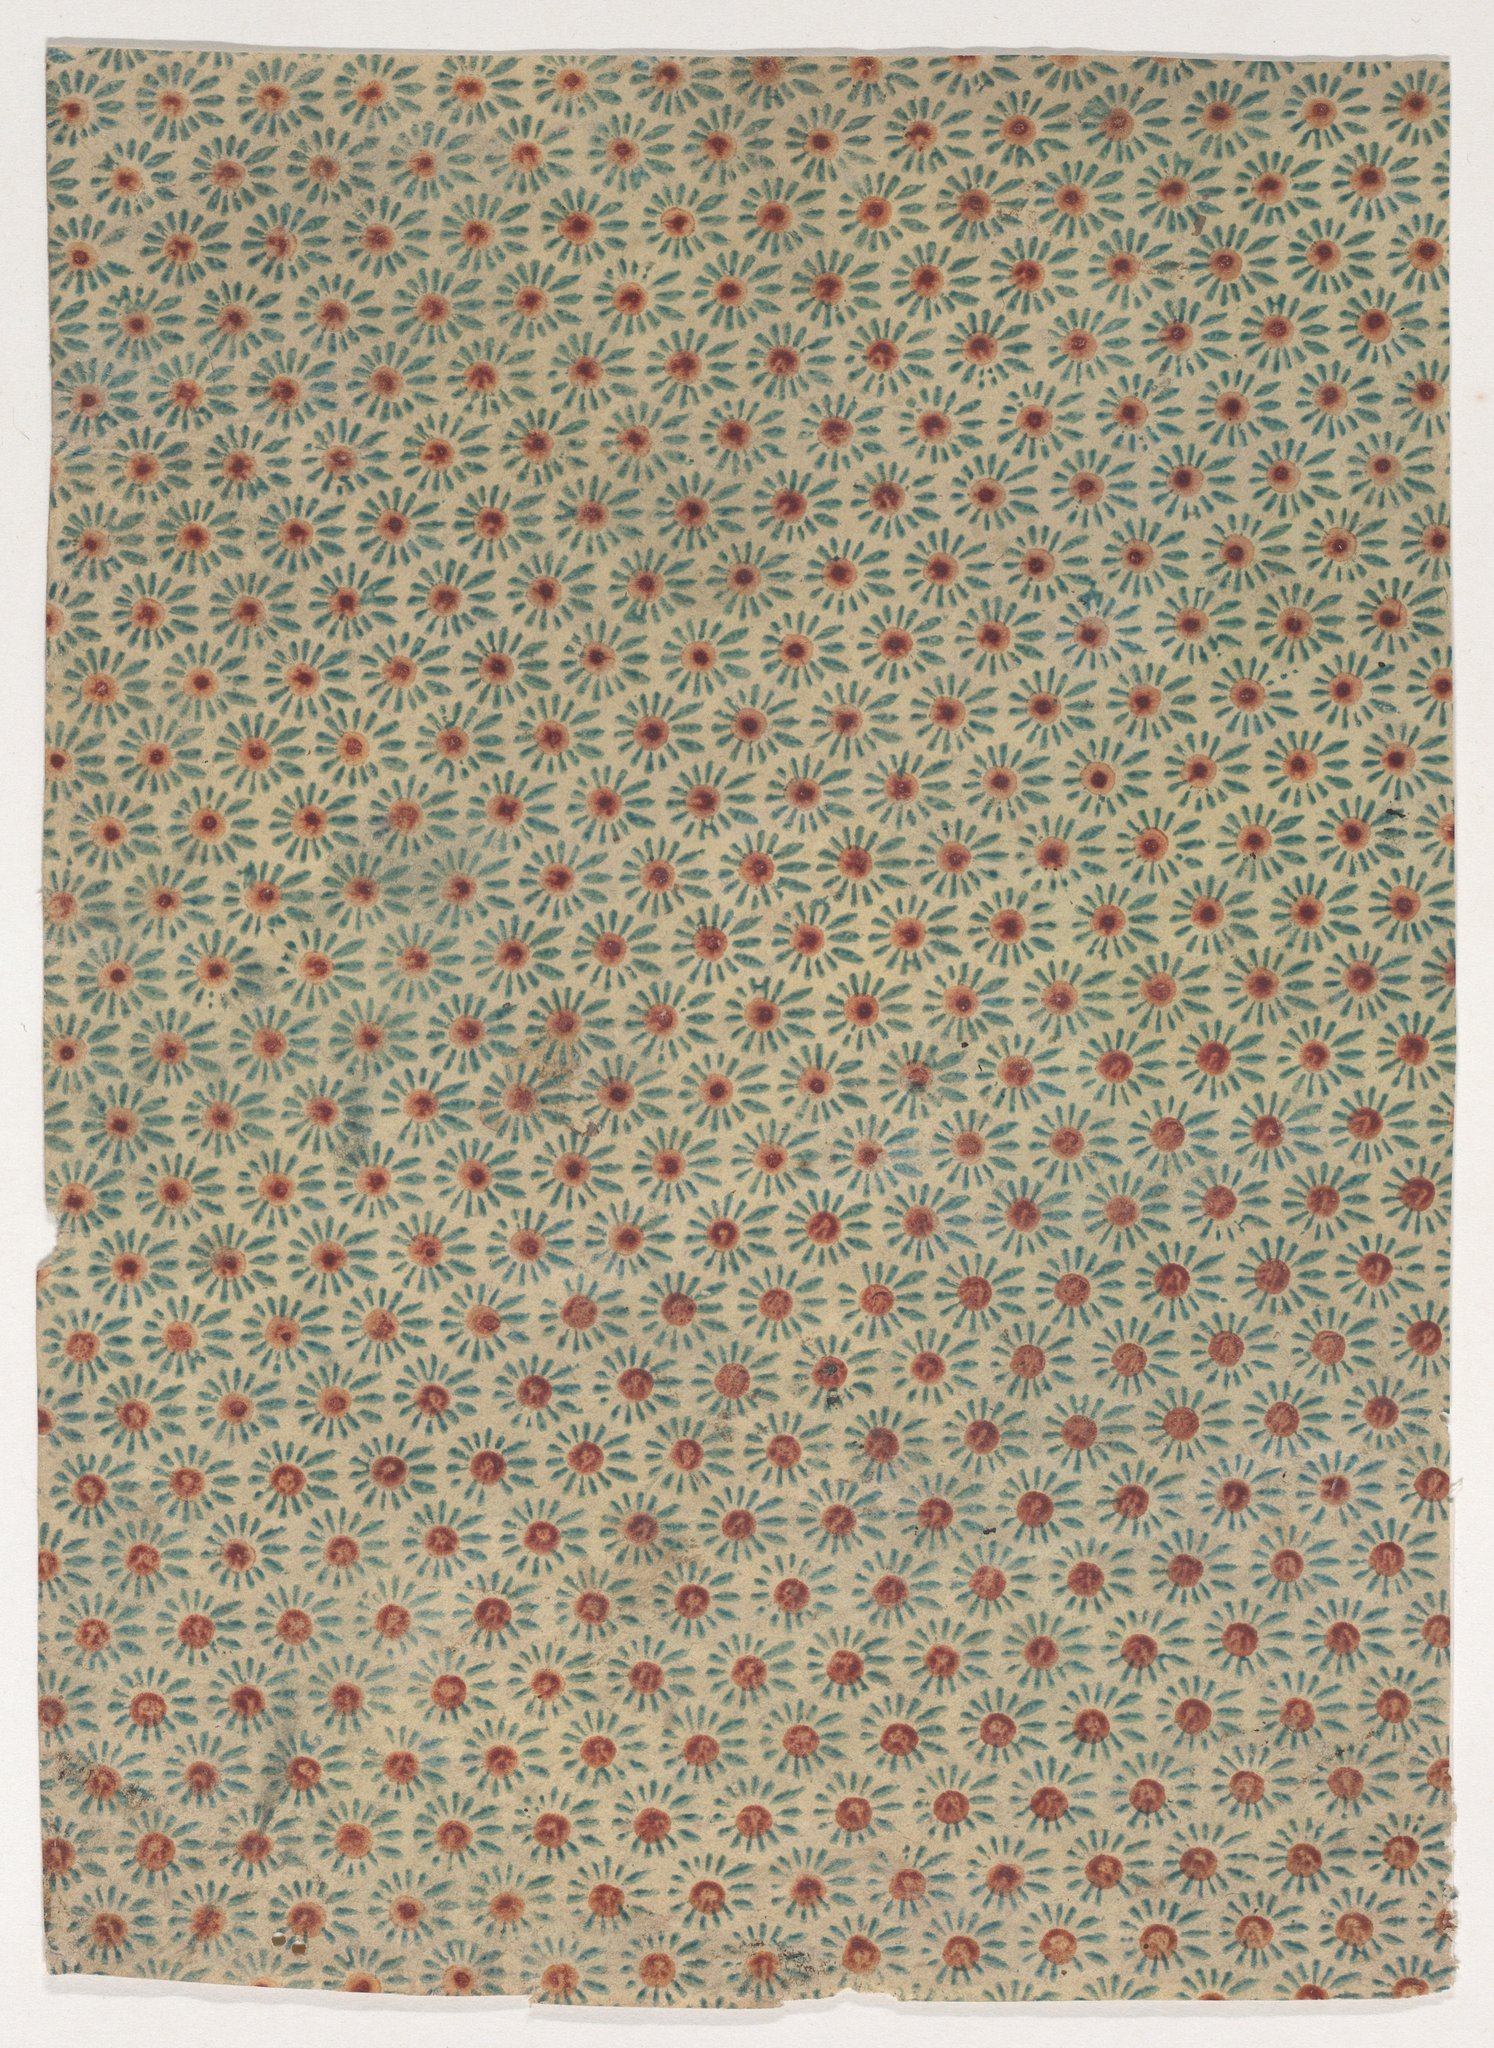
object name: print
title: Sheet with overall floral pattern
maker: Anonymous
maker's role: artist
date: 1801-1900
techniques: relief print